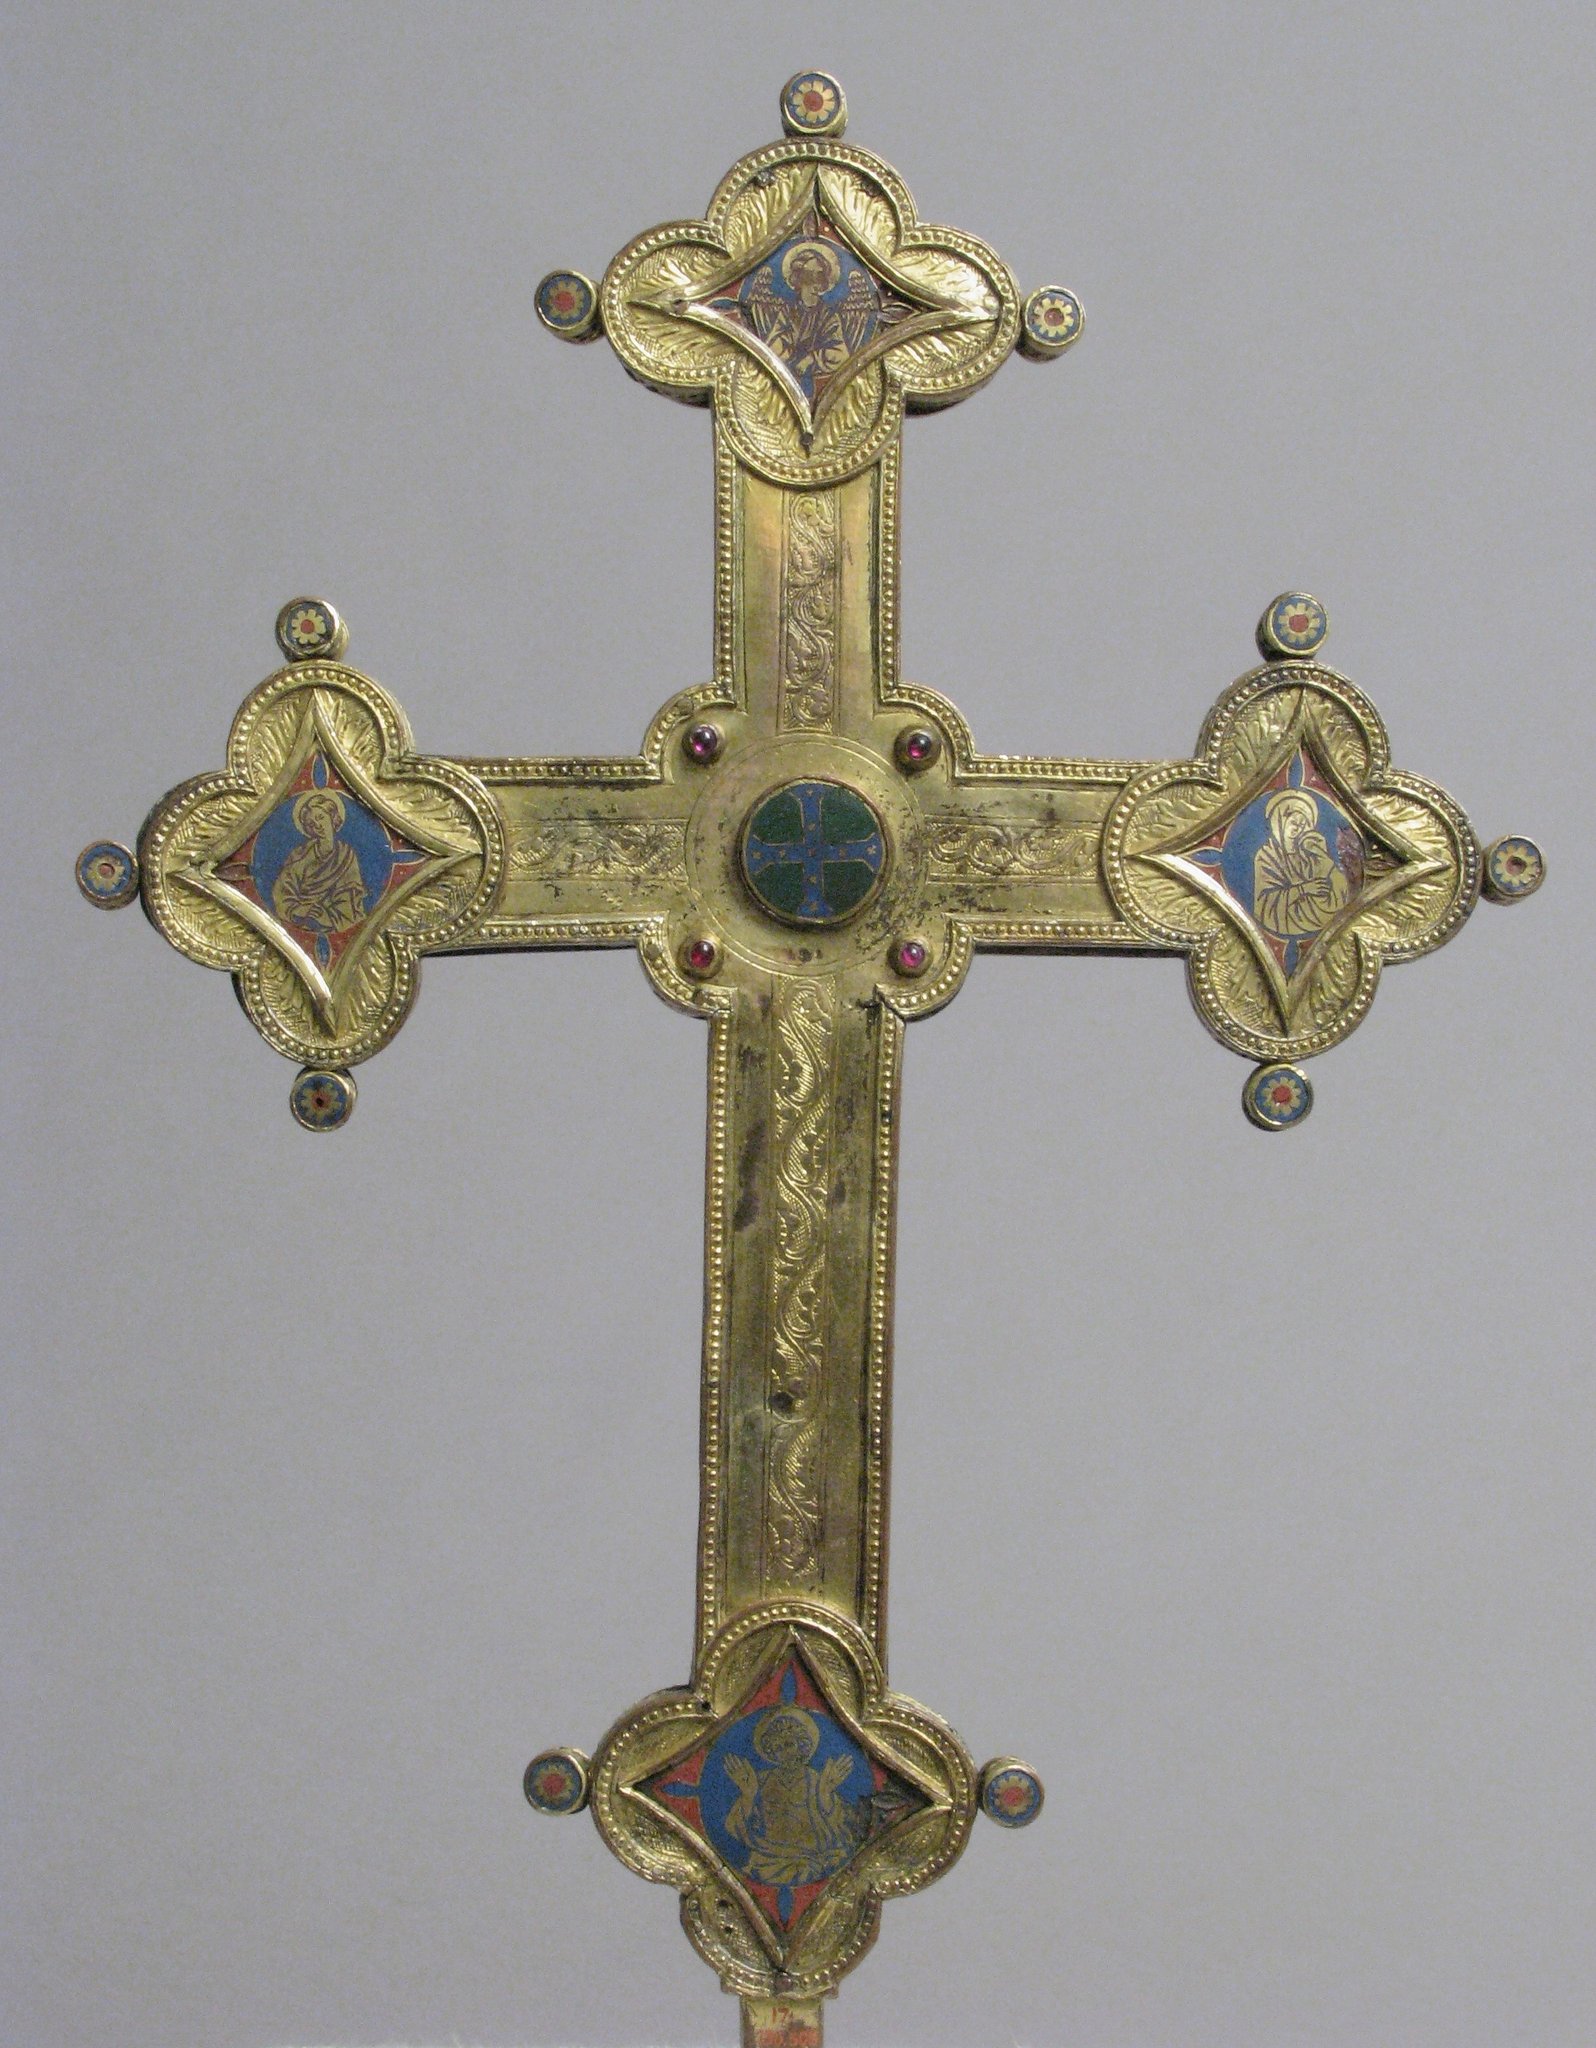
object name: cross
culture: italian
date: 1301-1500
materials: enamel, copper gilt, glass, stone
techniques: enamel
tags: cross